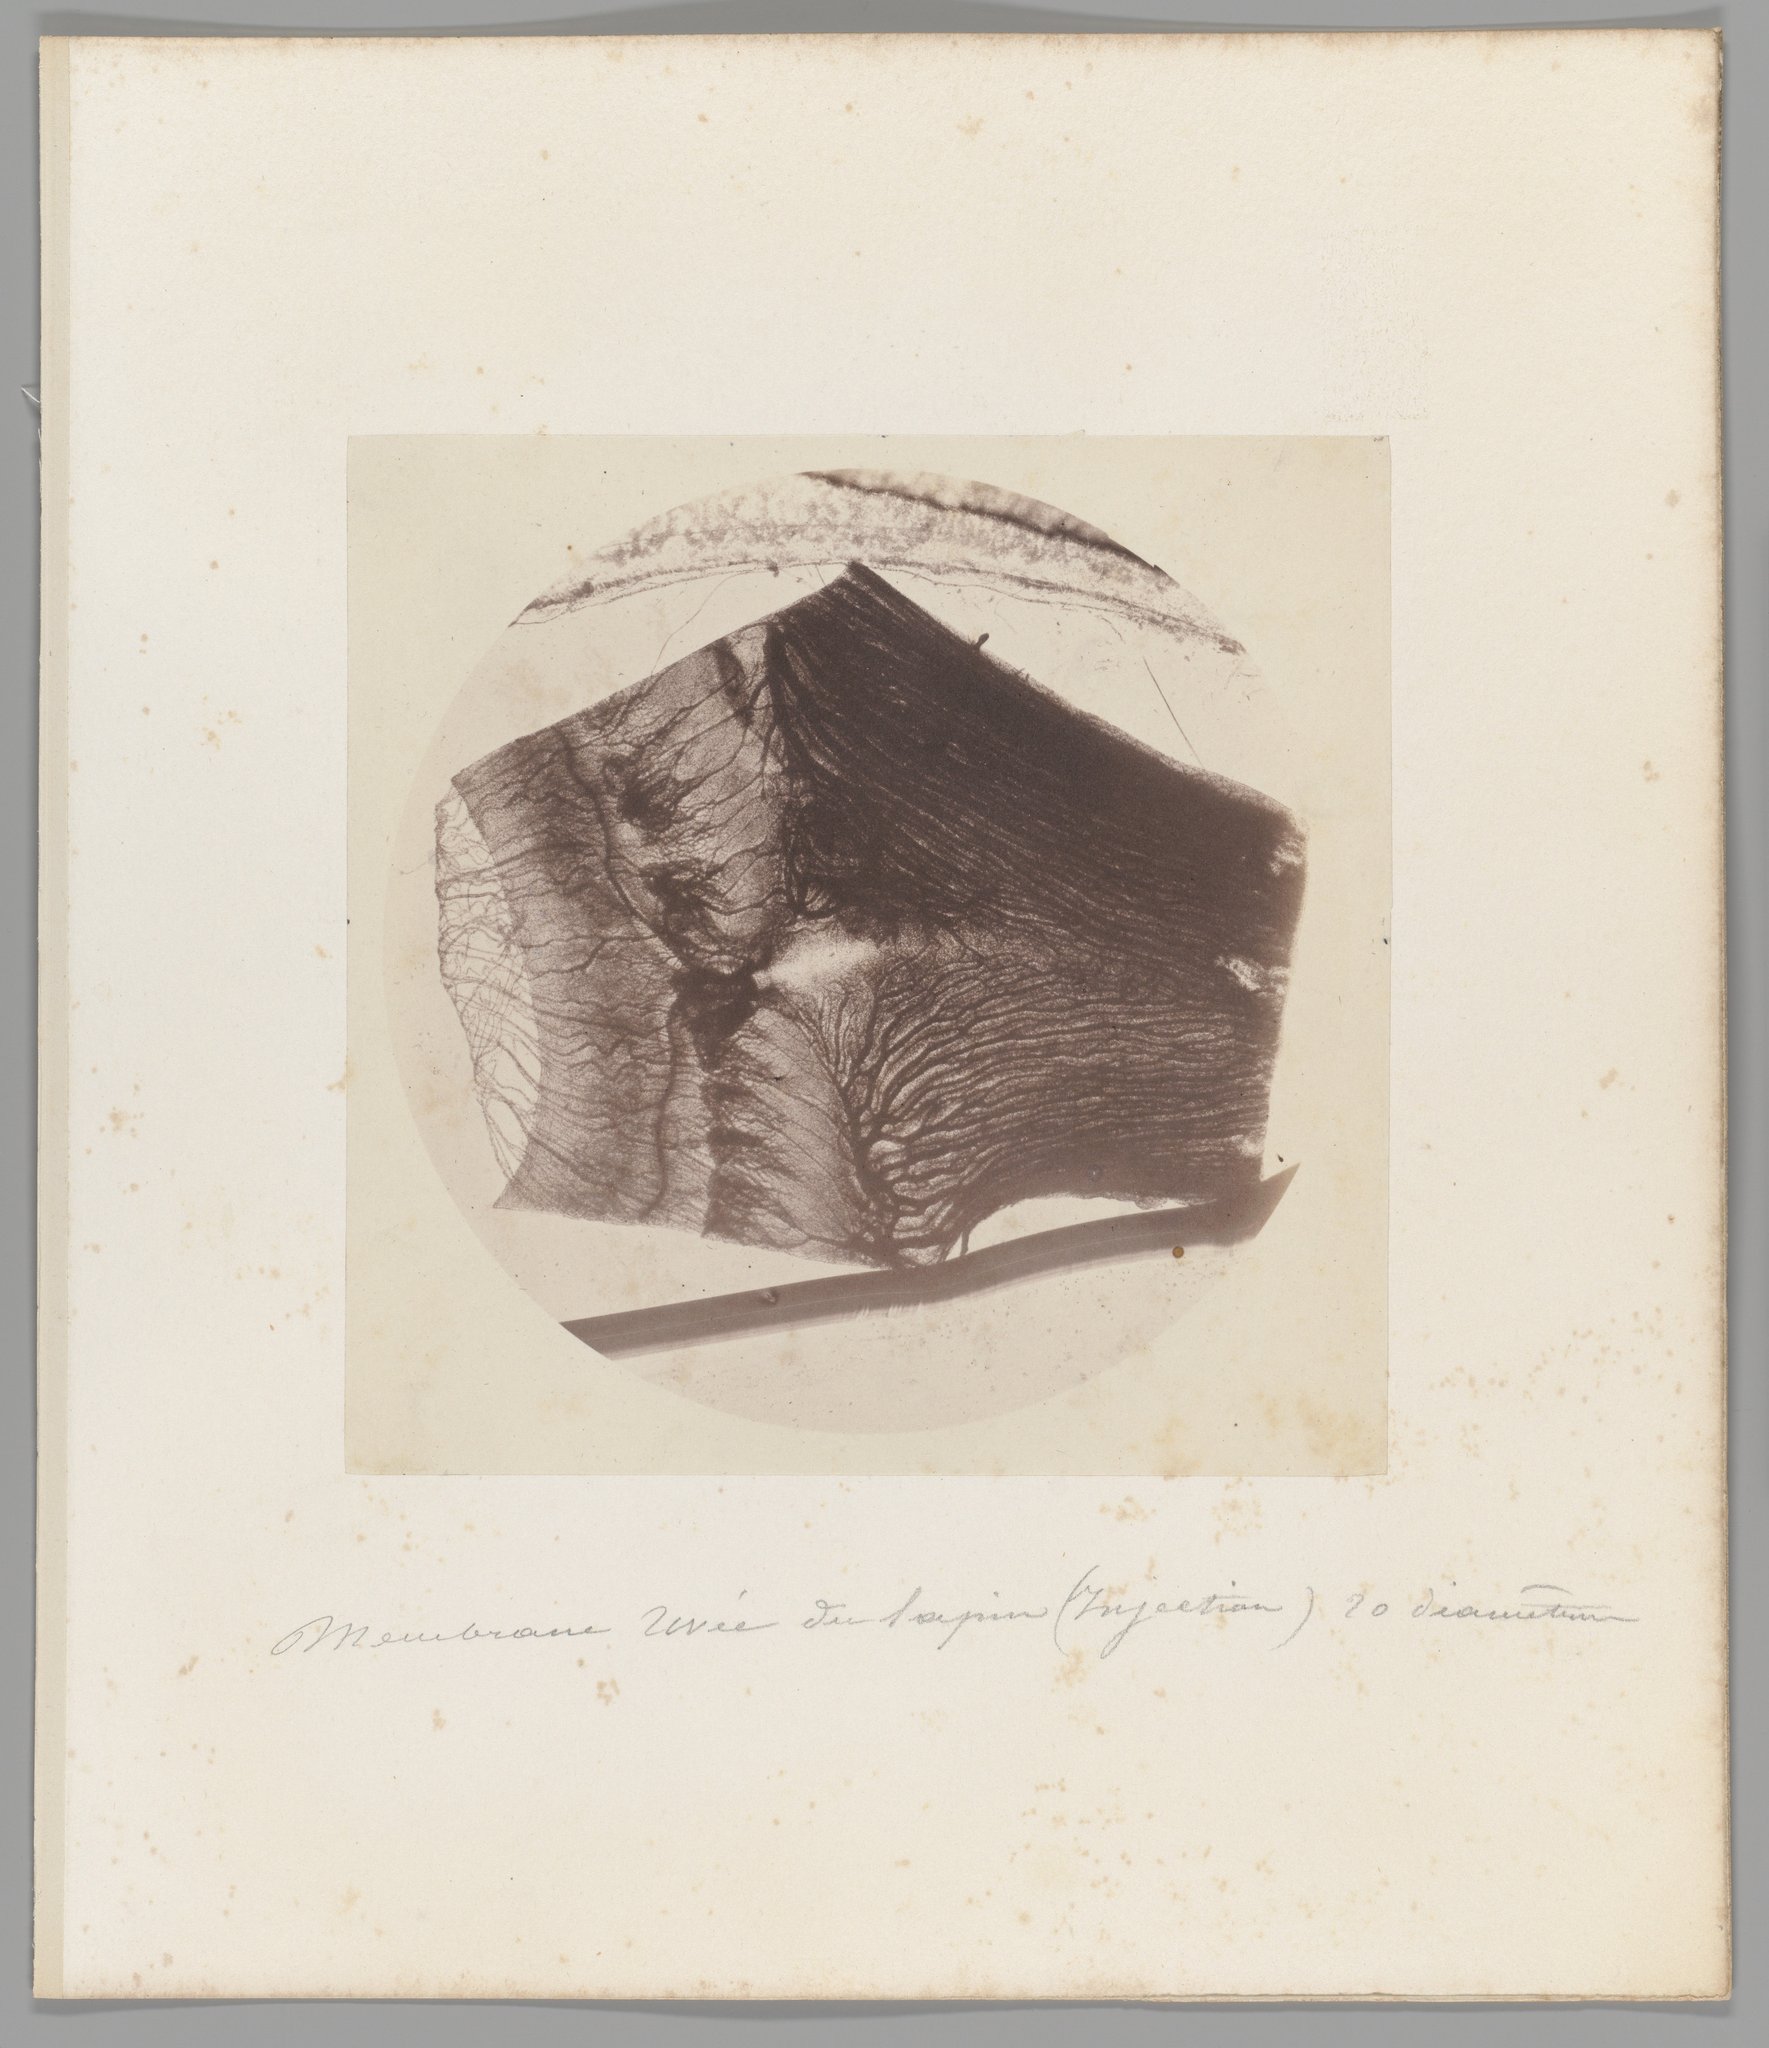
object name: photograph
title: [Untitled]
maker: auguste-adolphe bertsch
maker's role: artist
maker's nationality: french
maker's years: 1813-1871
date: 1853-1857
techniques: salted paper print